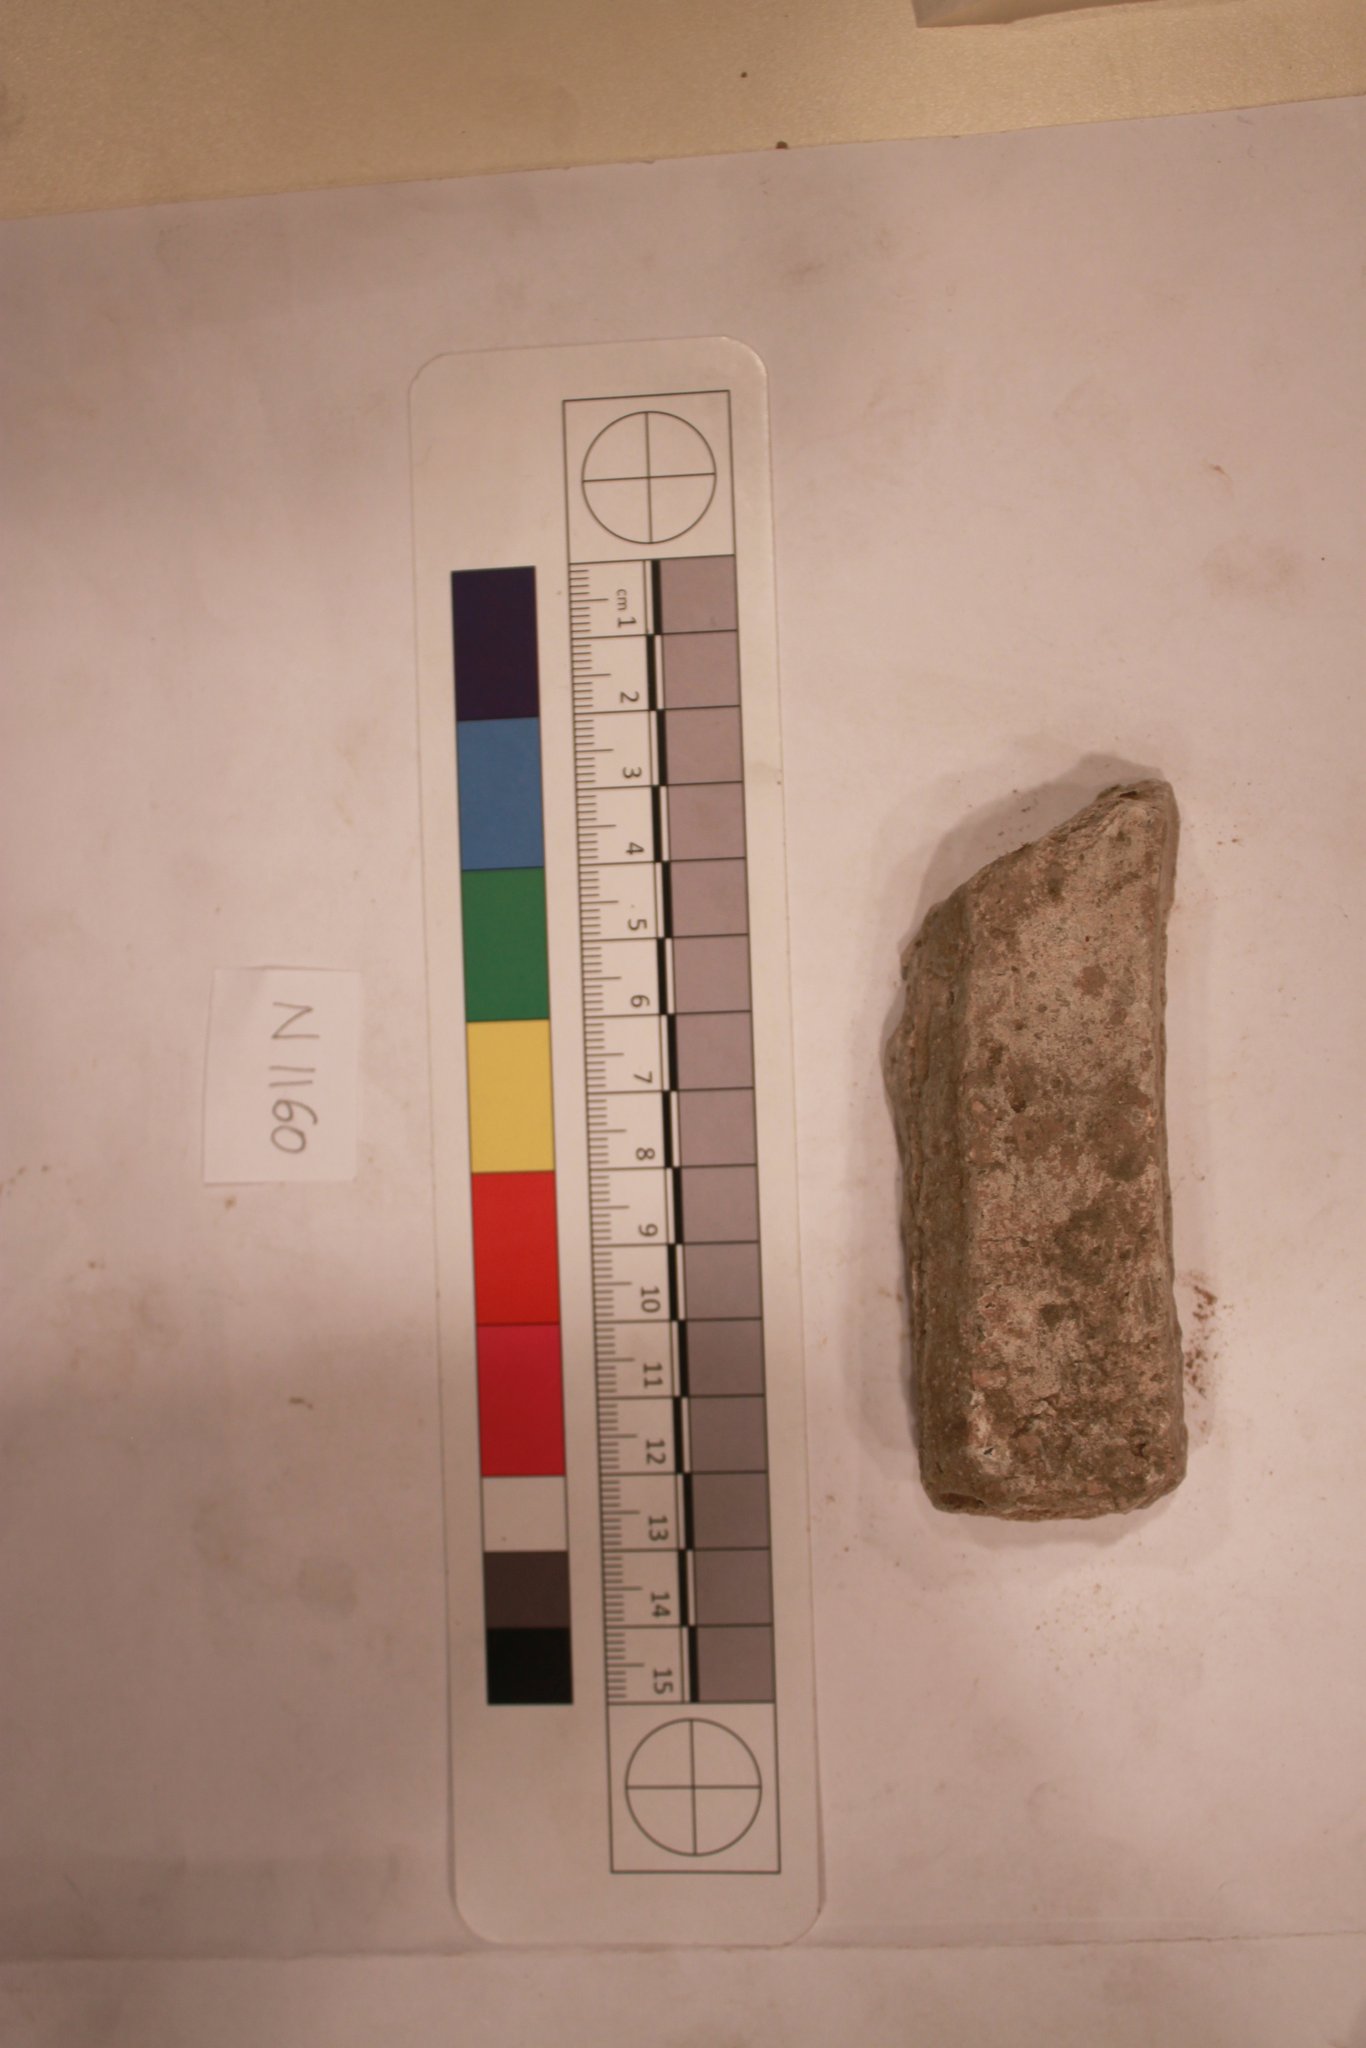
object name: fragment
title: Stucco Fragment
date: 701-1200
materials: plaster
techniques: carving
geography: iran